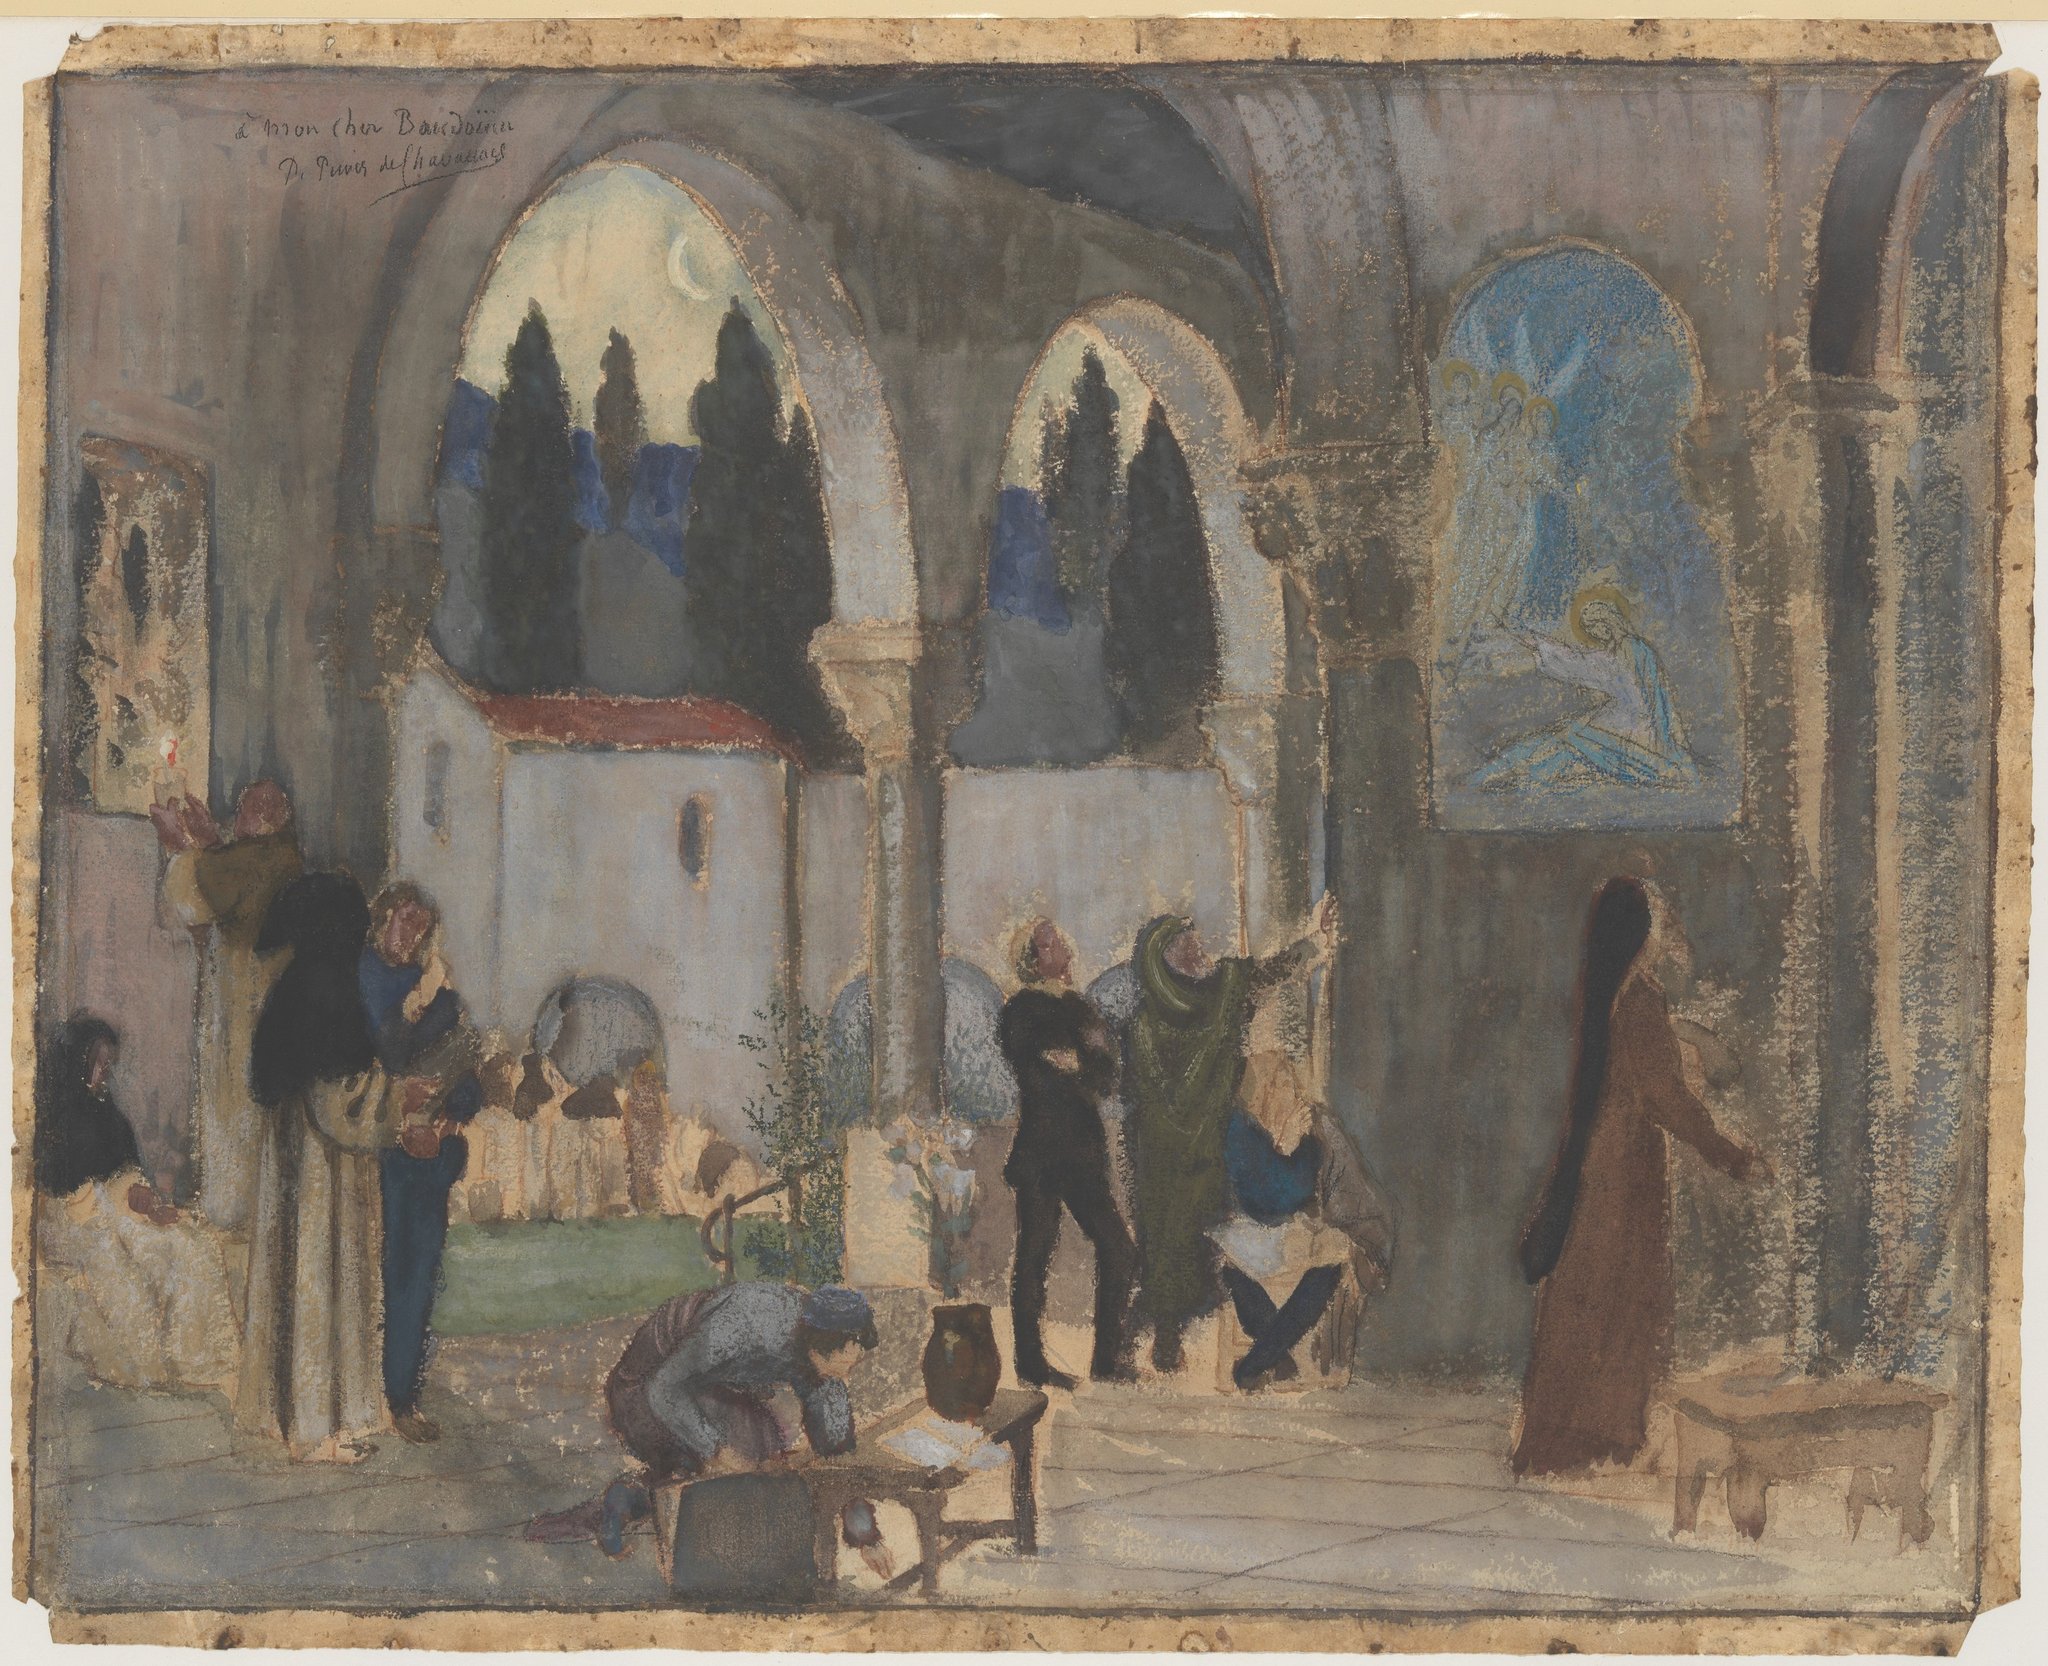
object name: drawing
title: Christian Inspiration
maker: pierre puvis de chavannes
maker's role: artist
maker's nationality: french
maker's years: 1824-1898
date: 1883-1886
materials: gouache, paper, pastel, watercolor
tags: men,women